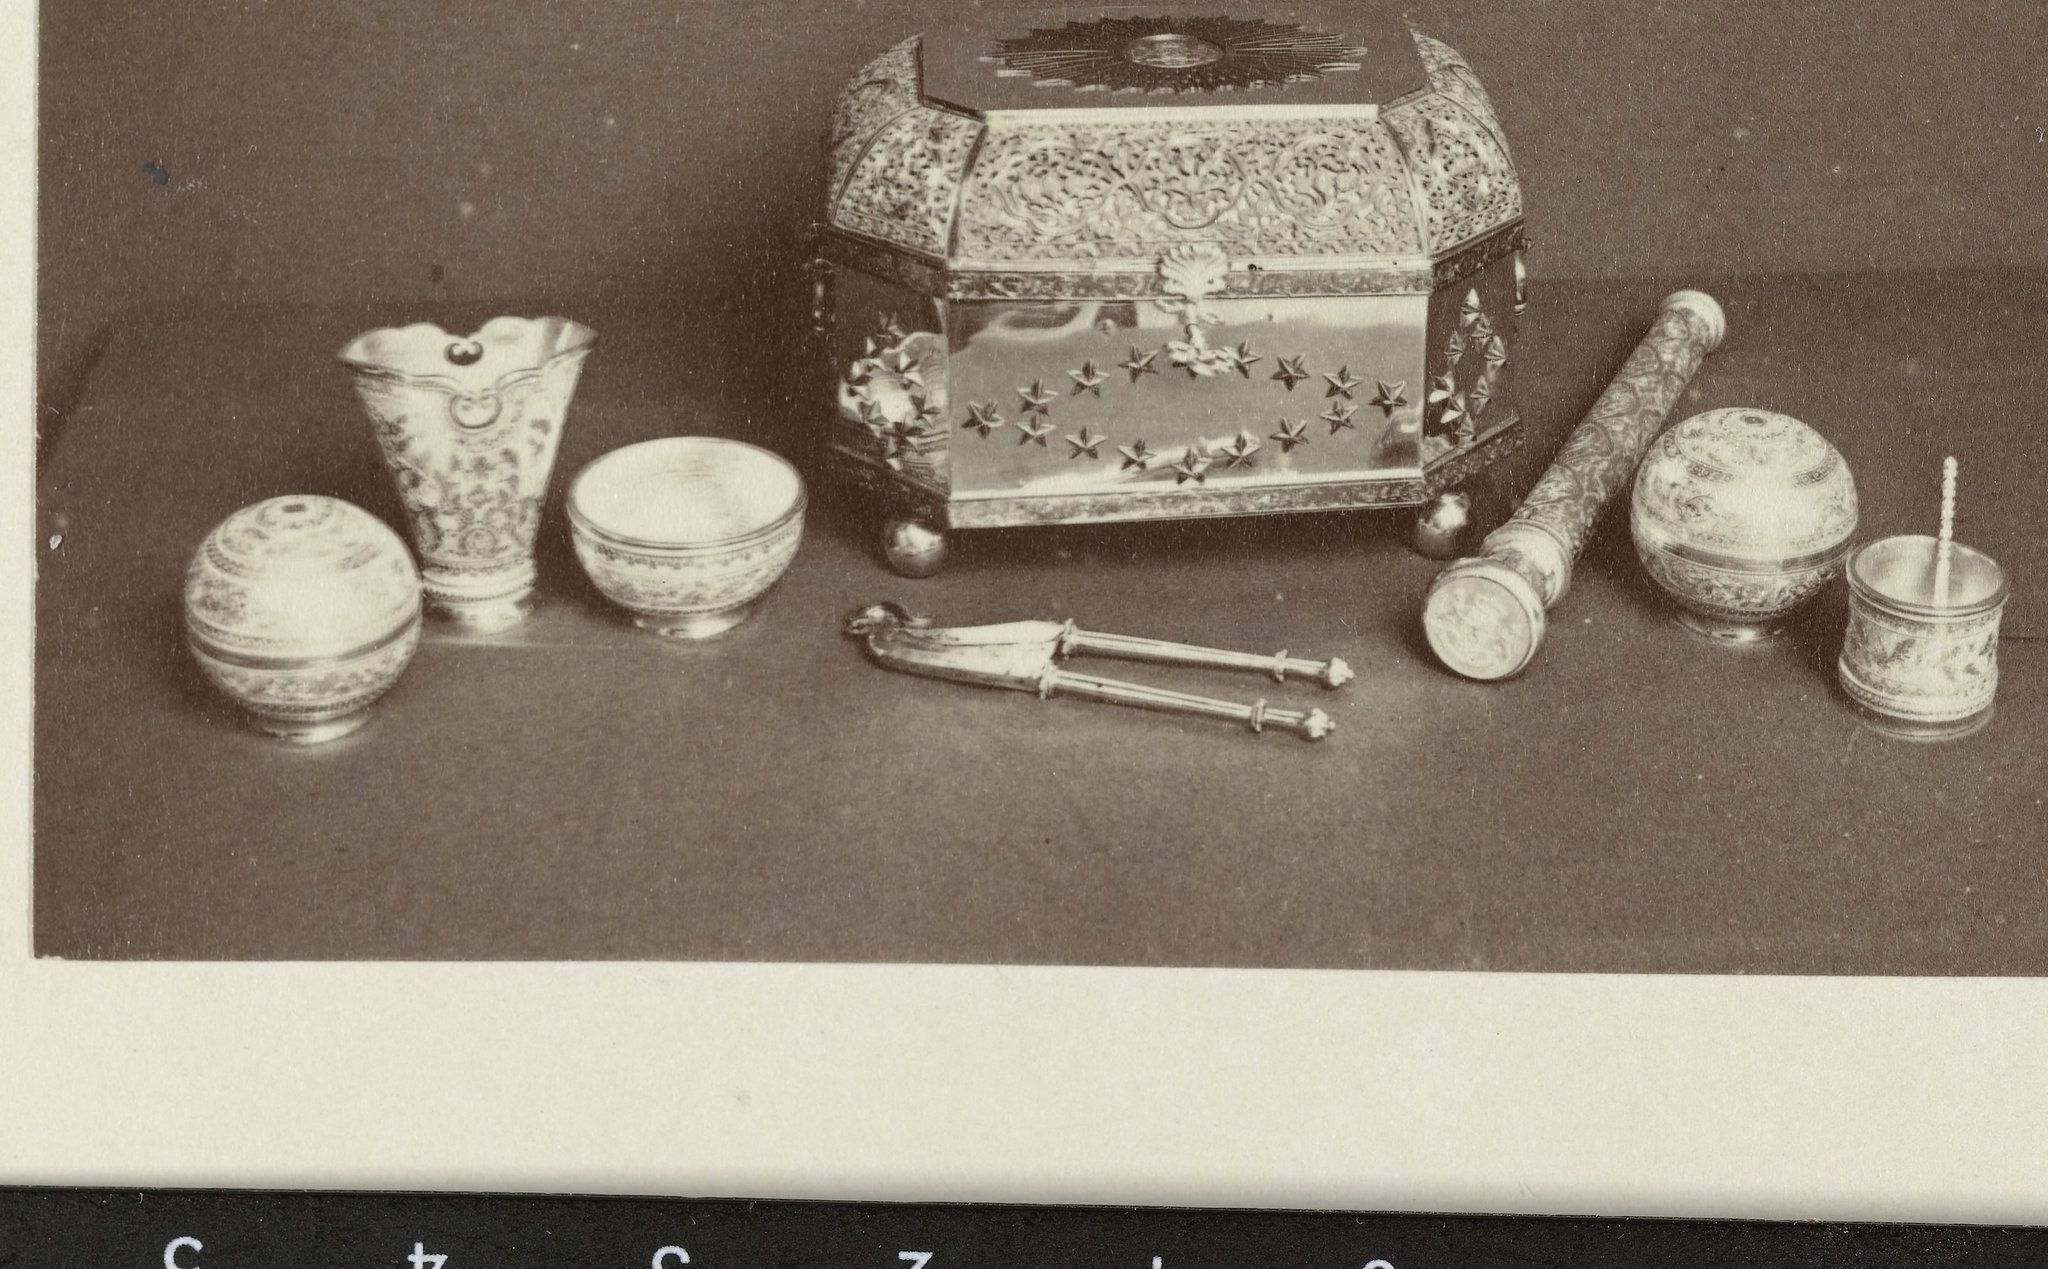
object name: photograph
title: Ceremonieel rookgerei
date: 1860-1890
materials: photographic support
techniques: albumen print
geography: batavia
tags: pipe ~ tobacco, java, batavia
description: Ceremonieel rookgerei. Ingeplakte foto in het fotoalbum getiteld: Gezichten van Java.